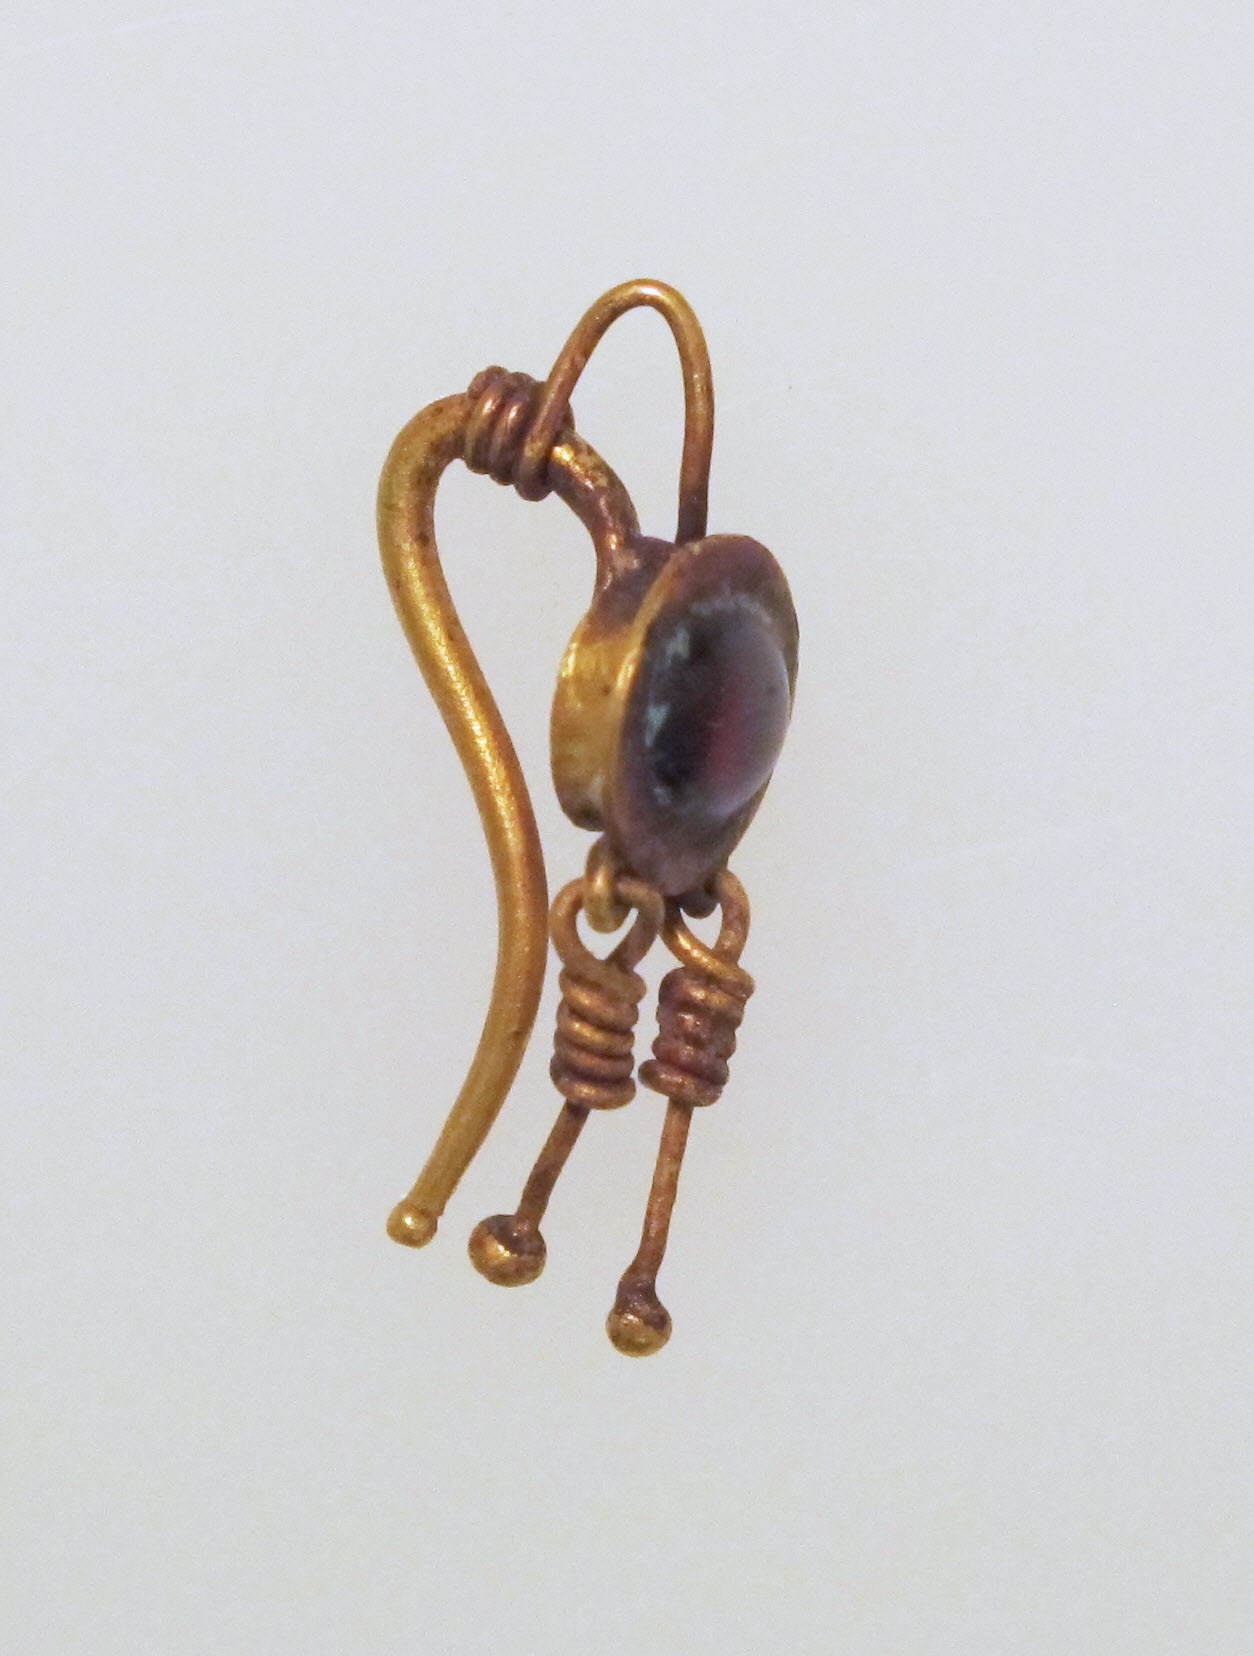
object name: earring hook type with pendant and ruby setting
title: Earring-hook type with pendants and ruby setting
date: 7000 BCE-330 CE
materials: gold, gemstone